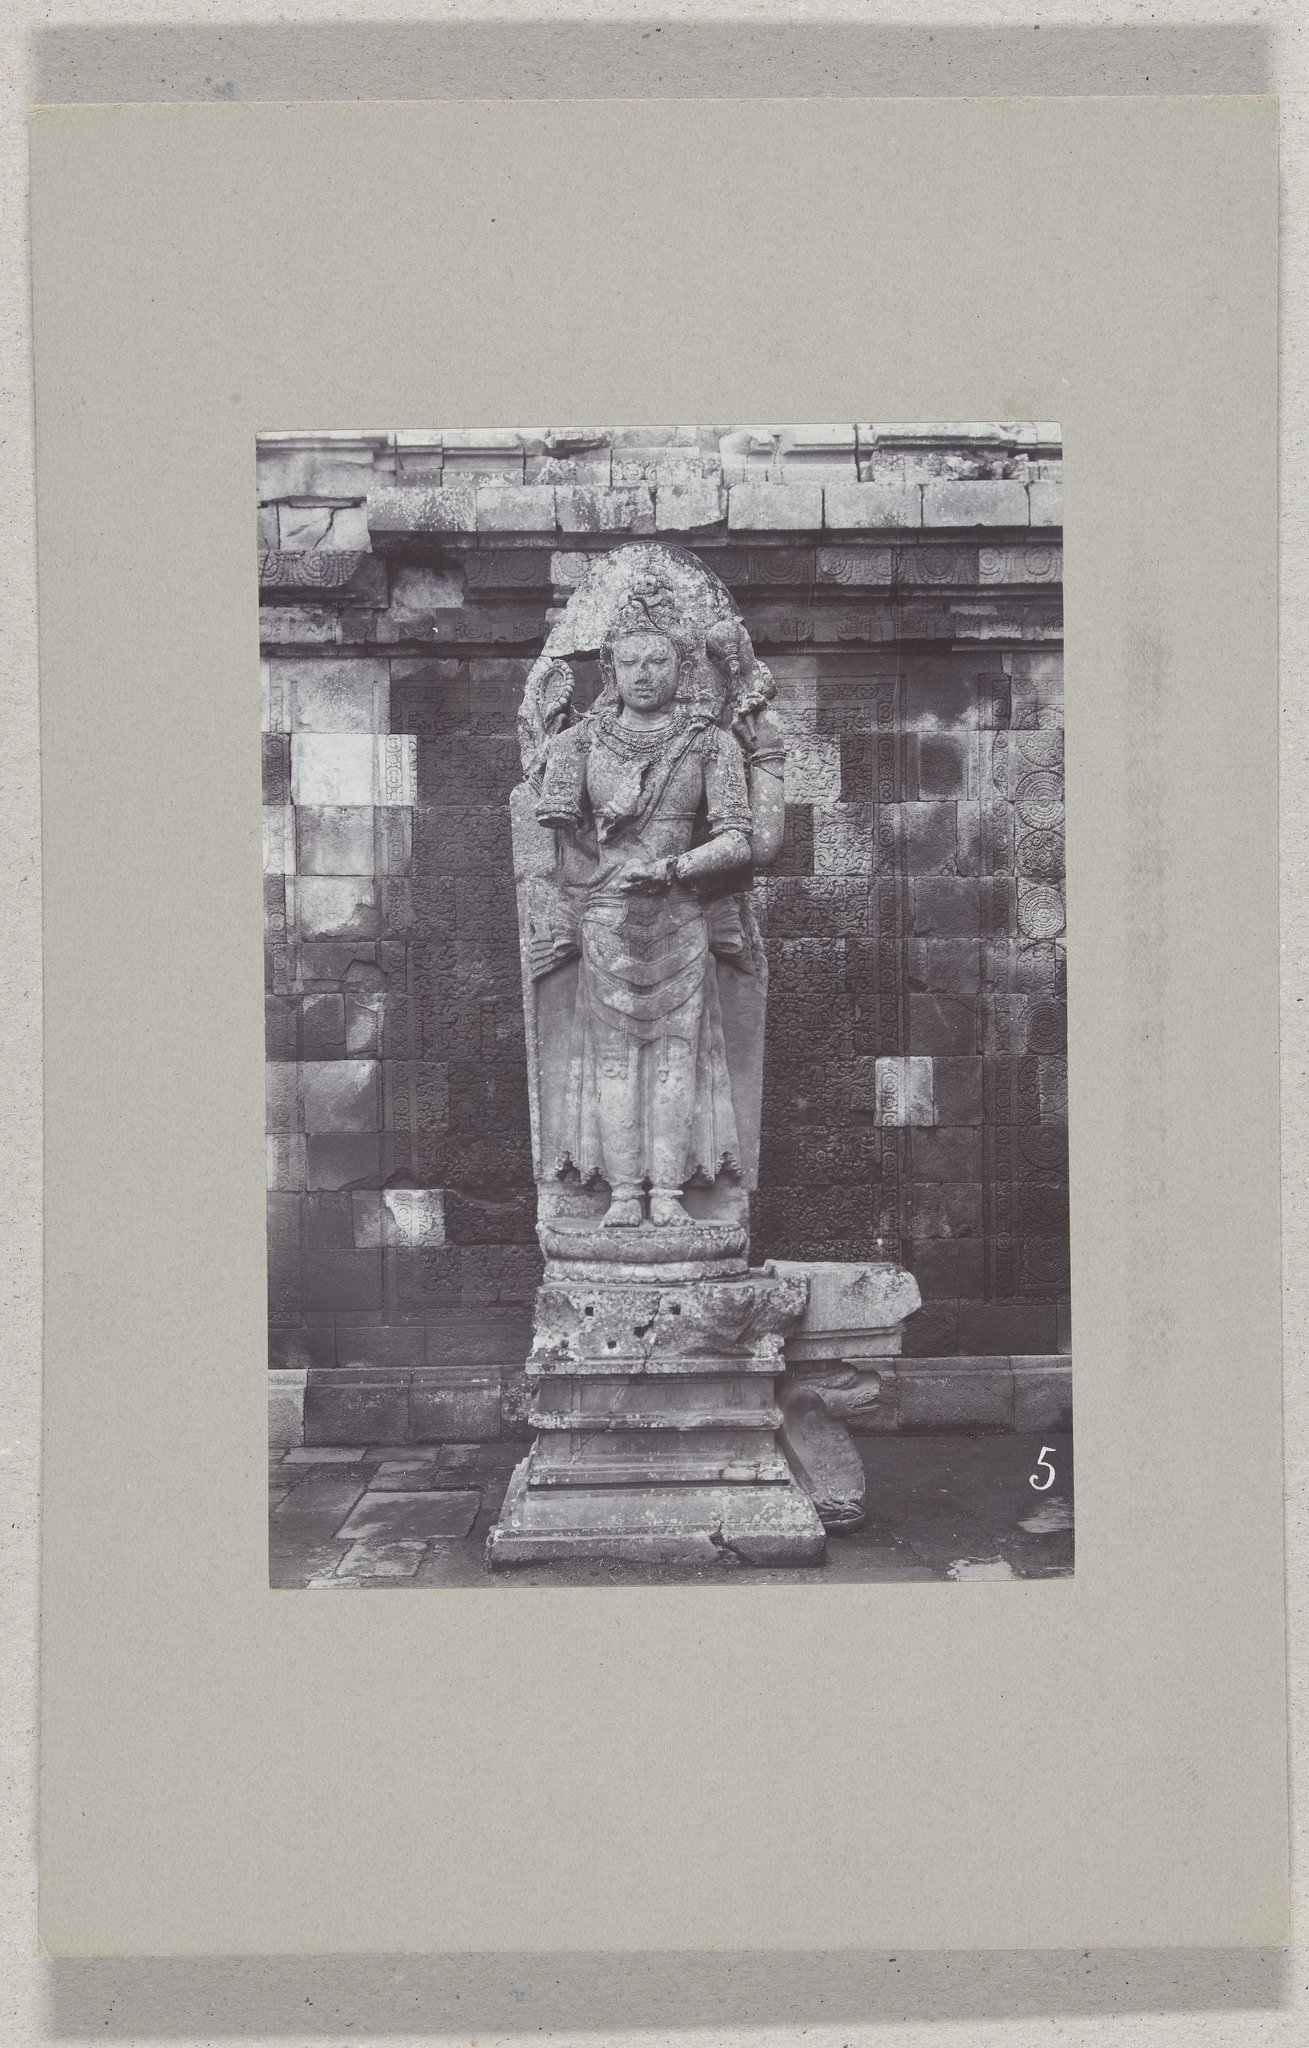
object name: photograph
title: Beeld in een tempel van Prambanan bij Jogyakarta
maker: Anonymous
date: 1895-1915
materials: cardboard, paper, photographic support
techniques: gelatin silver print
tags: indonesia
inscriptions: annotation: ‘84b Beeld in tempel a’, number: ‘5’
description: Beeld in een tempel van Prambanan bij Jogyakarta, Nederlands-Indië